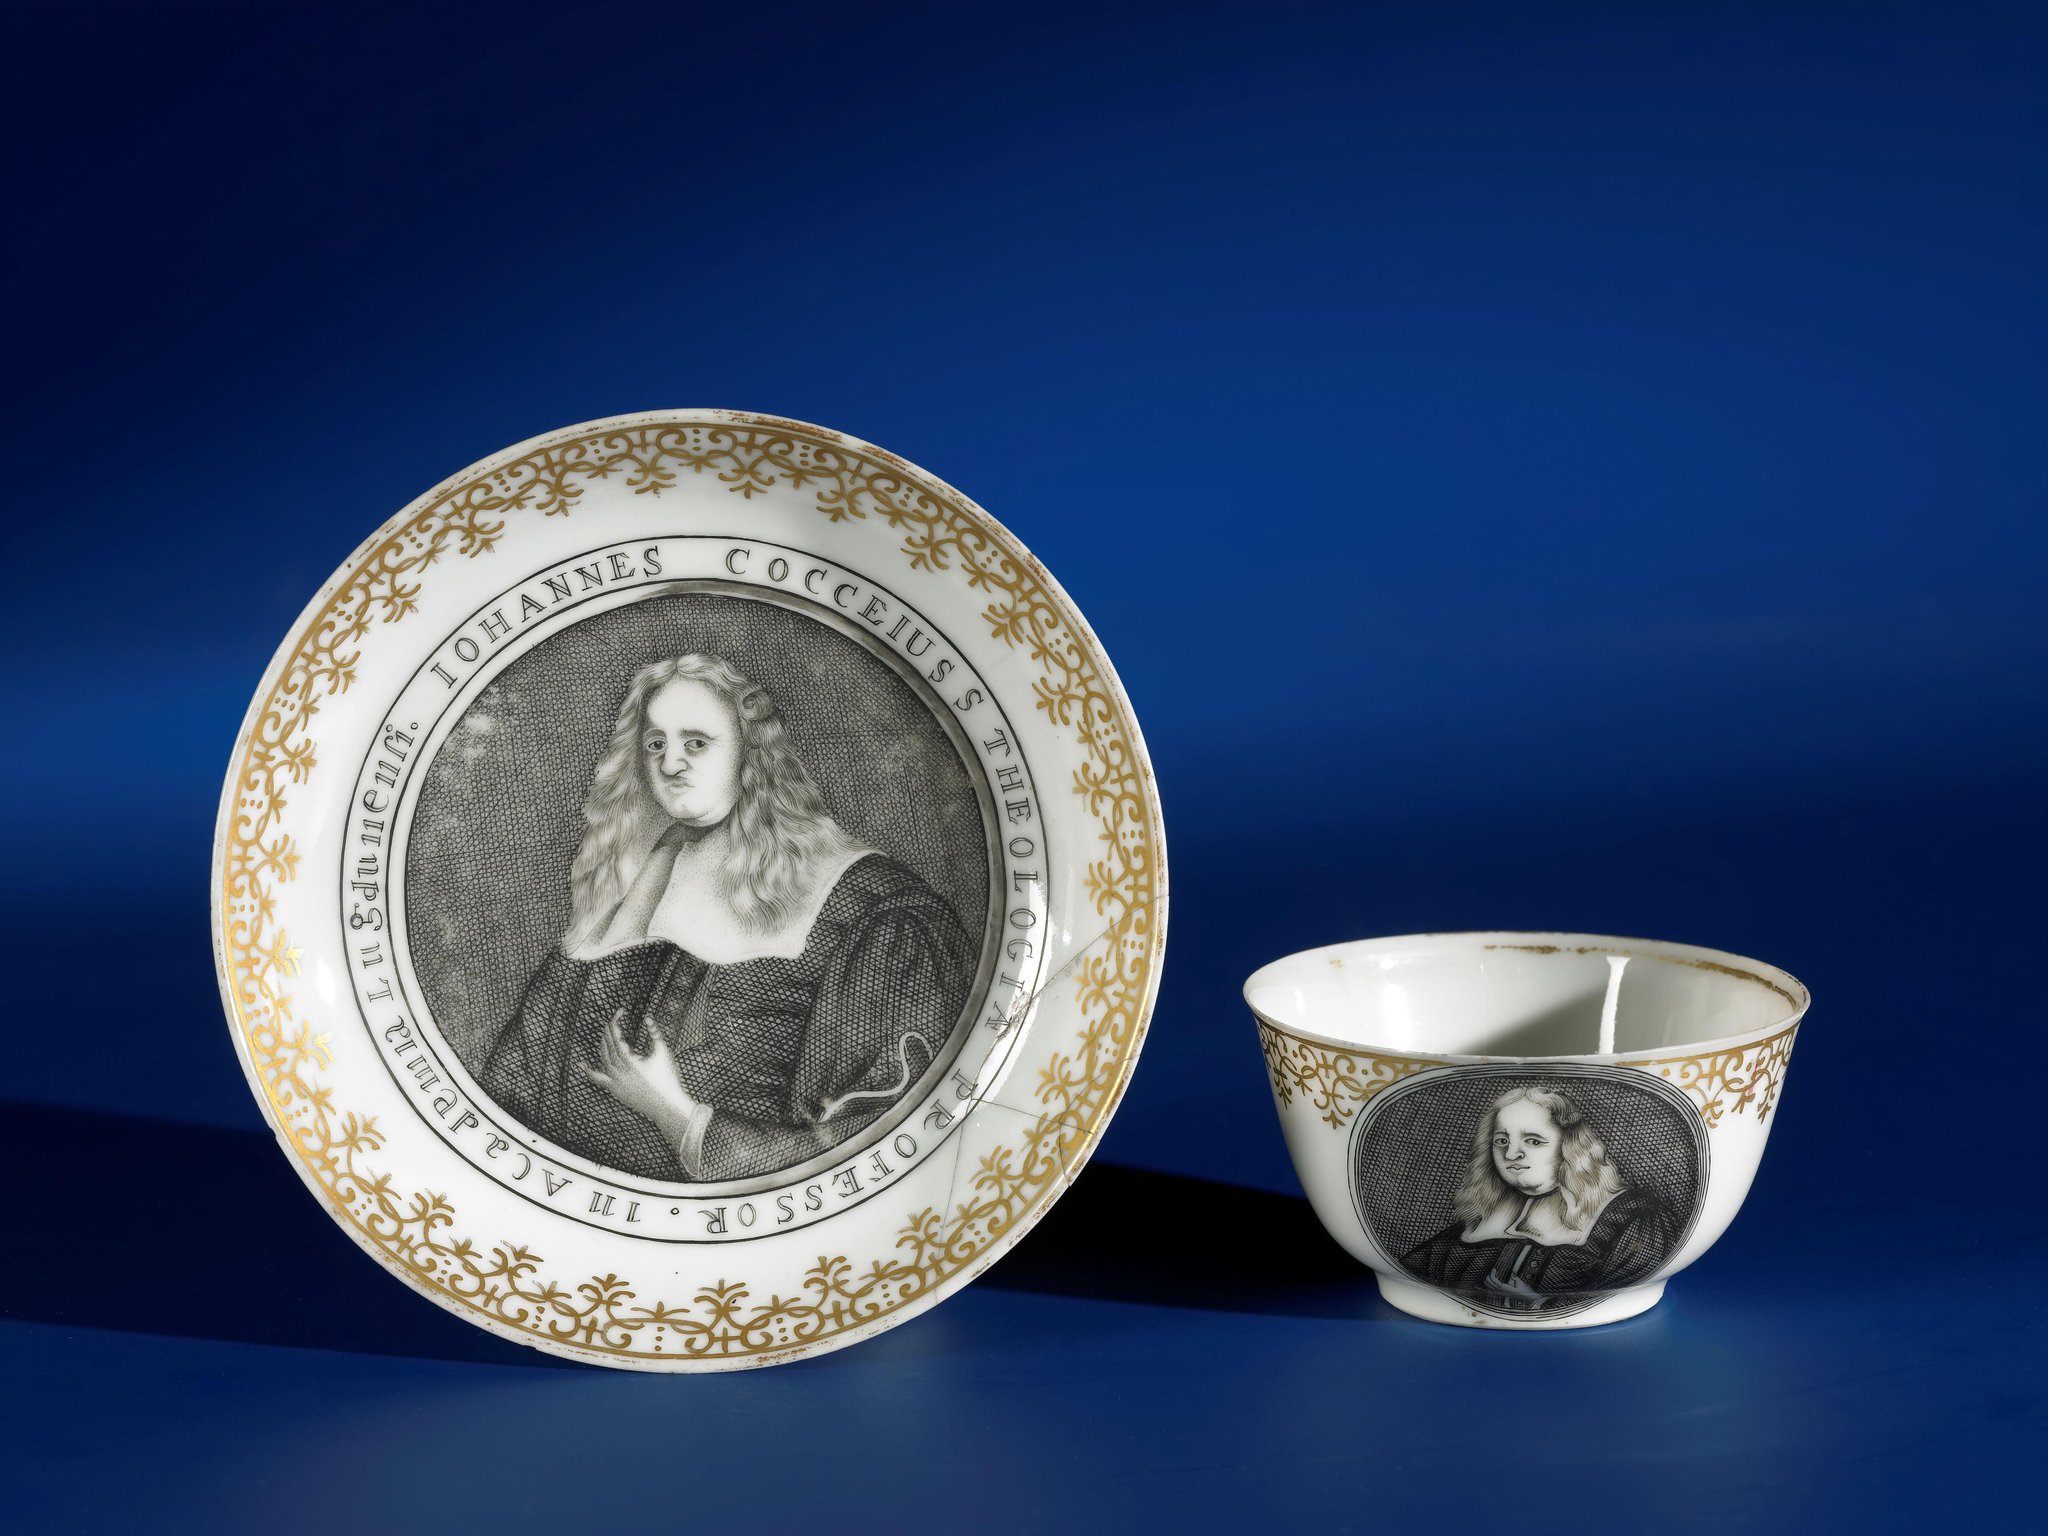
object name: platter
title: Saucer with a portrait of Johannes Cocceius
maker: Anonymous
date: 1725-1749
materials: glaze, gold, paint, porcelain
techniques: firing, gilding, turning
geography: china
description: Kop en schotel beschilderd in encre de Chine en goud met in het plat van de schotel en op de buitenwand van de kop (in een medaillon) een portret van de theoloog Johannes Cocceius (1603-1669). Rond het portret op de schotel de tekst: 'Iohannes Cocceius theologia progessor in academia lugdunensi'. Rond de rand van de kop en de binnenrand van de schotel een decoratieve band in goud.